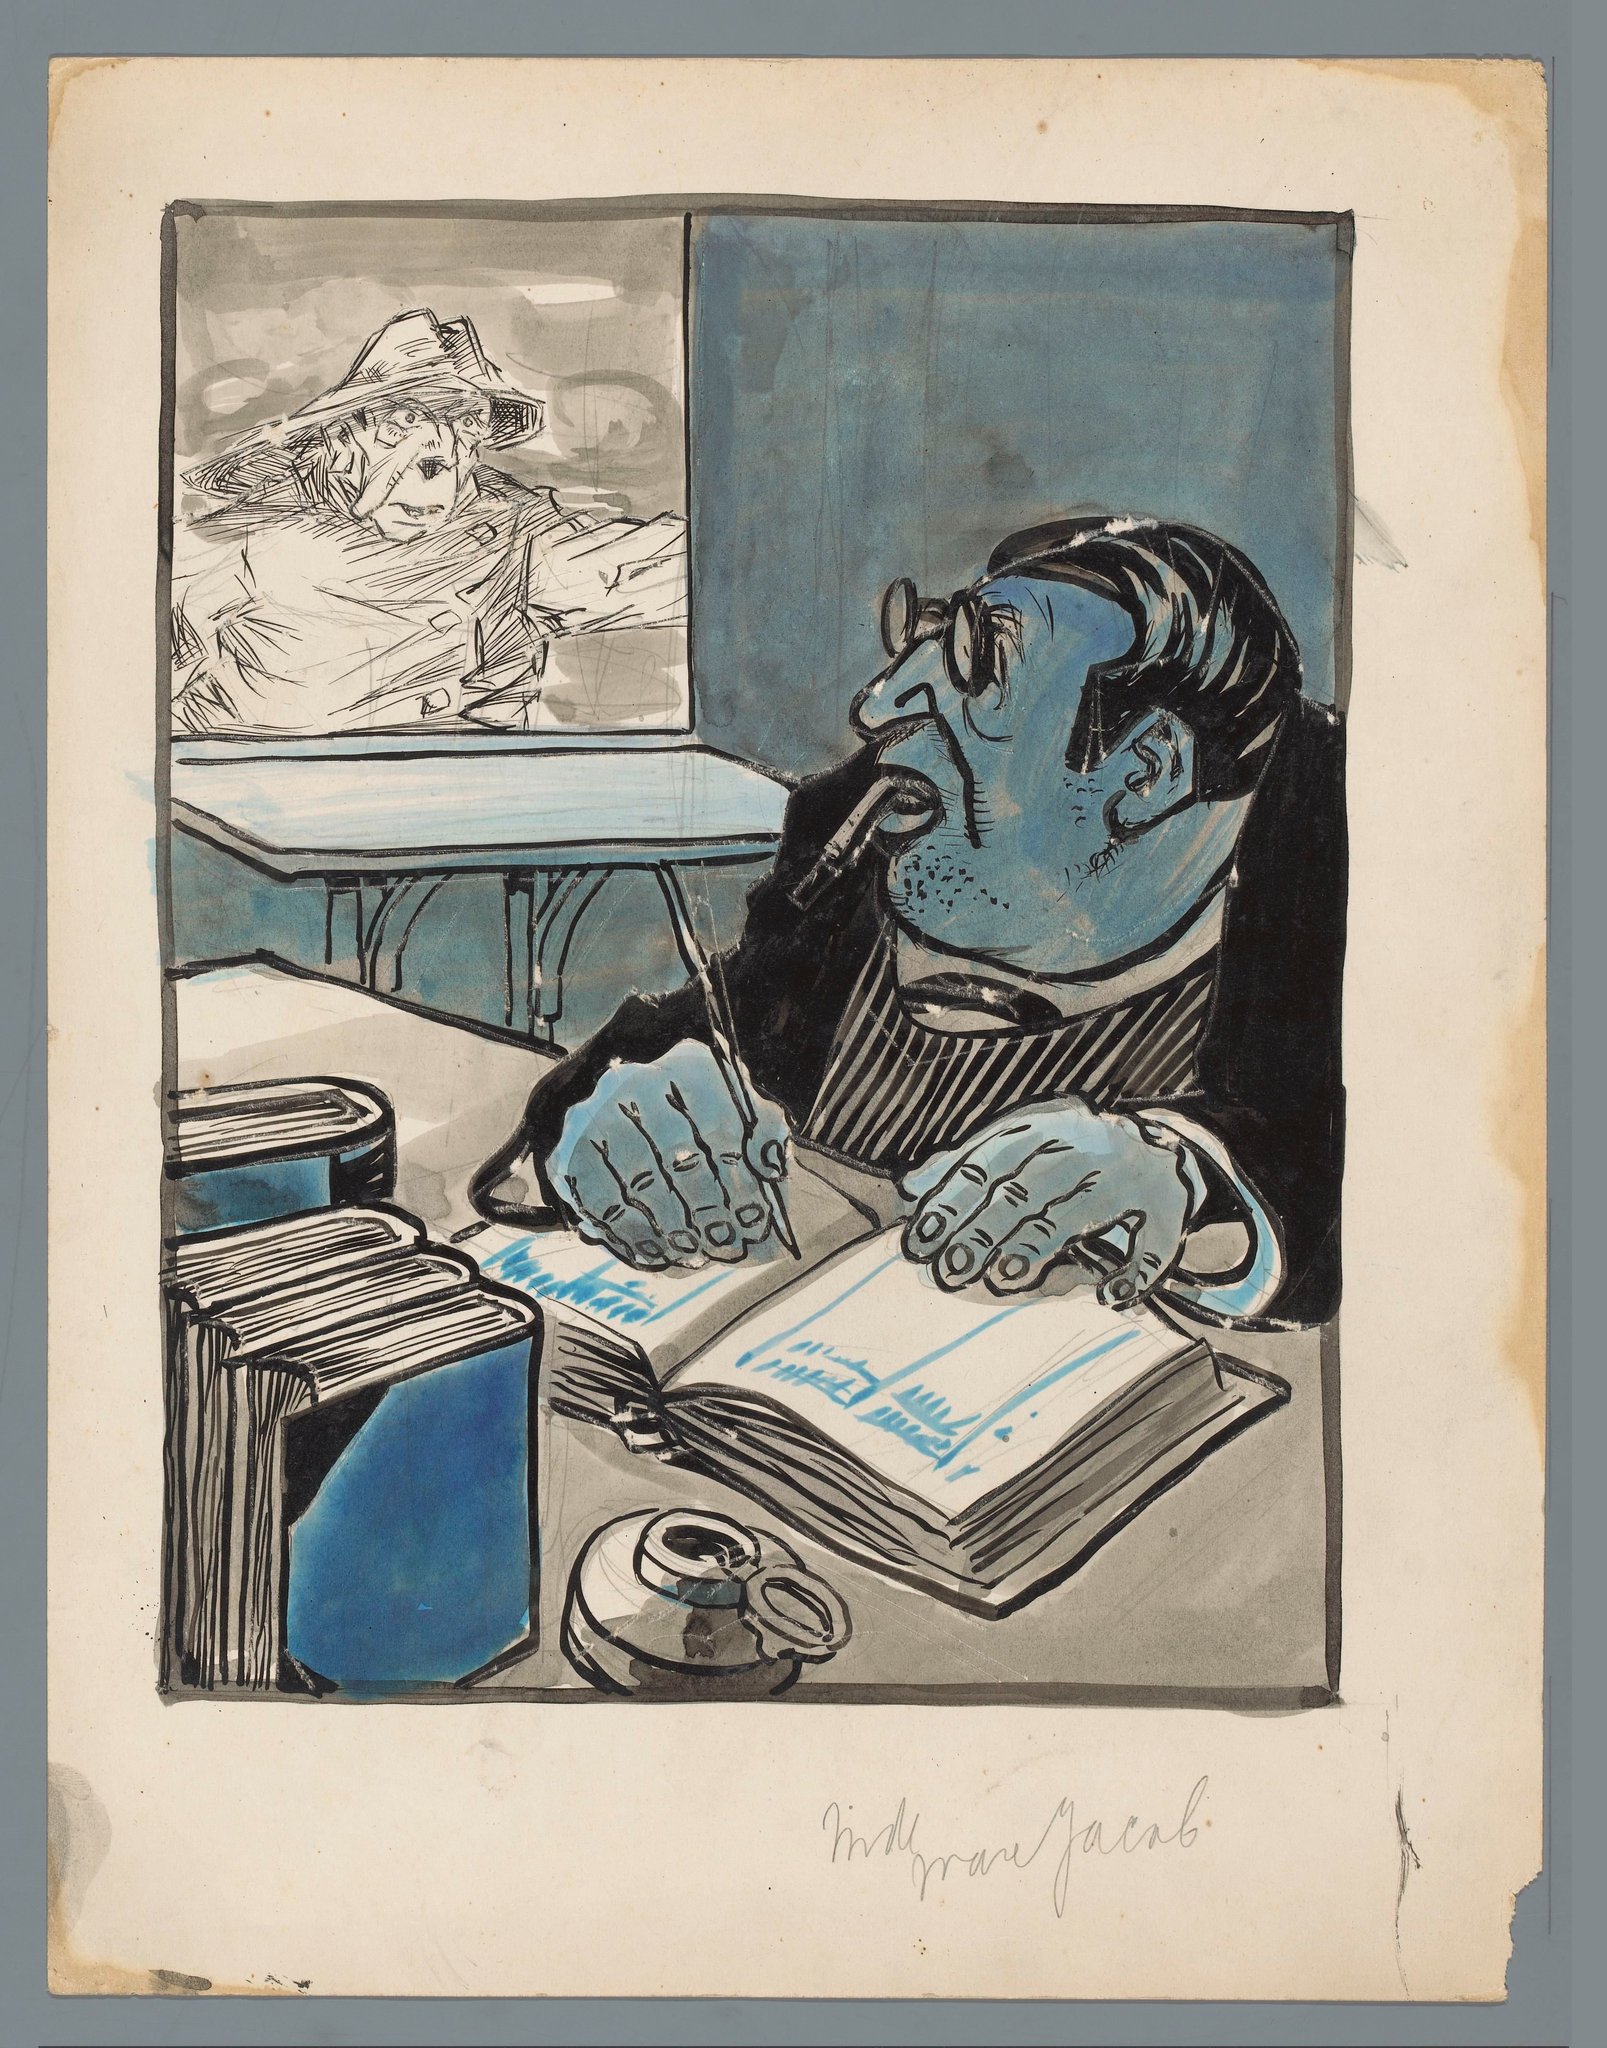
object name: drawing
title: Boekhouder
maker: patricq kroon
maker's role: draughtsman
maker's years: 1862-1941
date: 1900-1935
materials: ink, paint, paper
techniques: brush, pen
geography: netherlands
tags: book-keeping, accountant, political caricatures and satires, netherlands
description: Een dikke boekhouder op kantoor aan het werk ziet door het raam een man in een zuidwester. Op de achterzijde van het blad een variant van dezelfde voorstelling. Ontwerp voor een politieke spotprent in het blad De Ware Jacob.